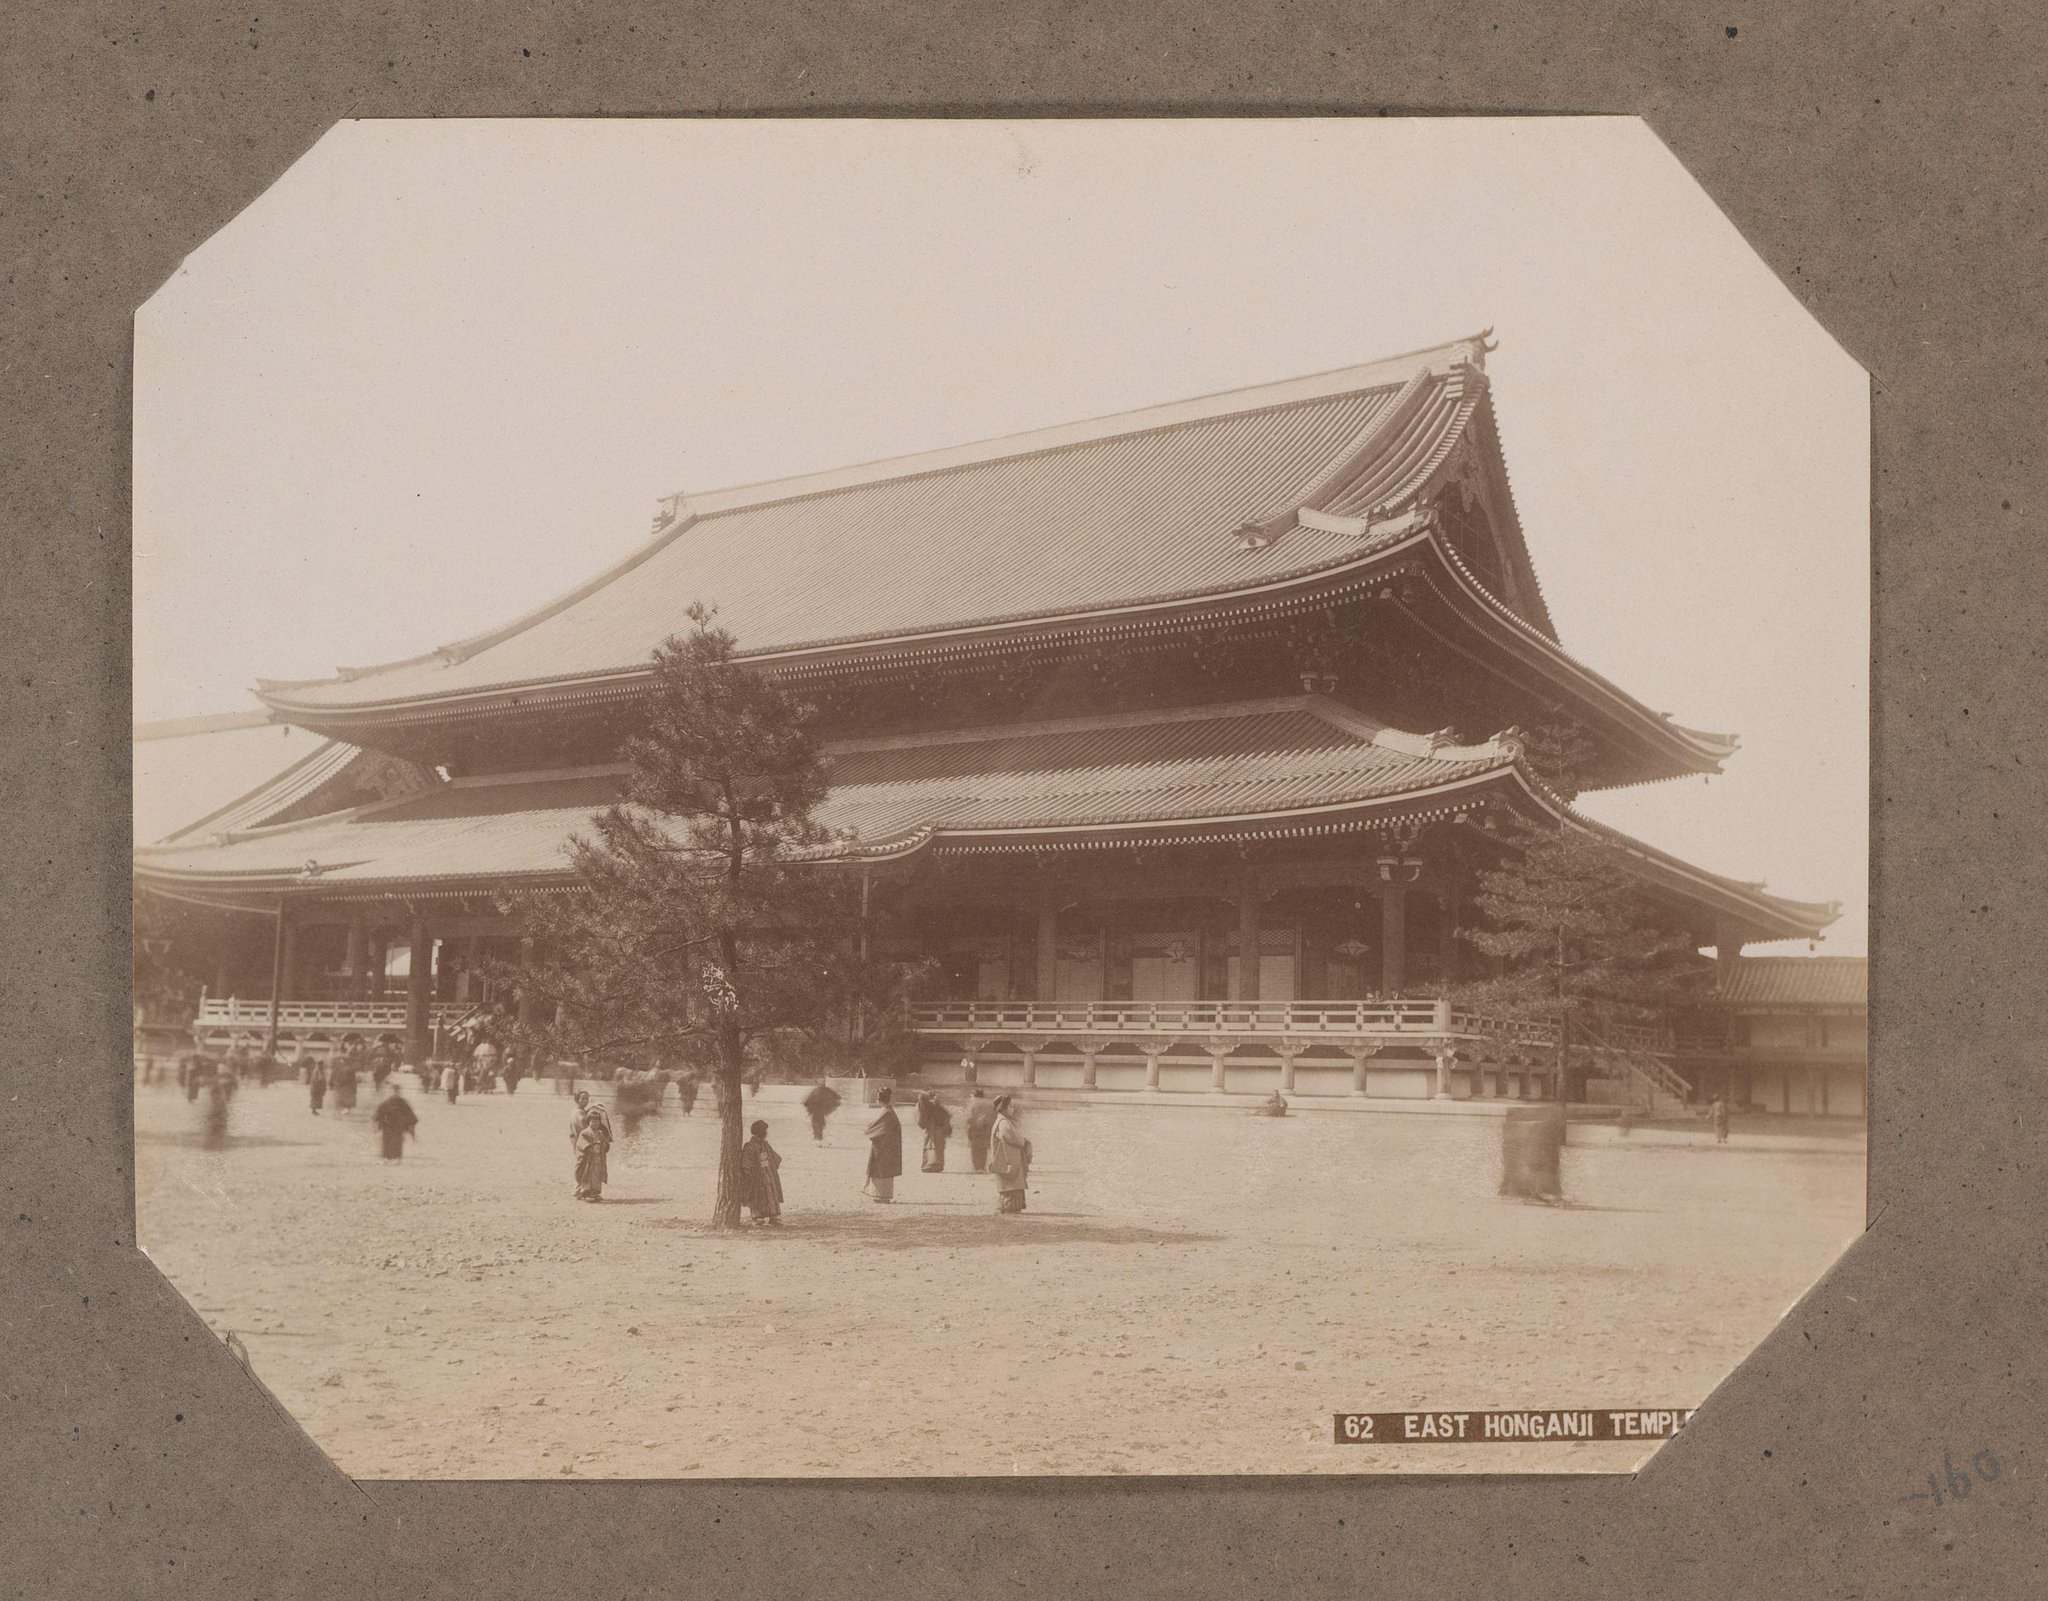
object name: photograph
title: Gezicht op de oostzijde van de Nishi Hongan-ji tempel in Kyoto, Japan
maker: Anonymous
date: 1890-1903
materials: paper, photographic support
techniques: albumen print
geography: kyoto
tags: temple, shrine ~ hinduism, buddhism, jainism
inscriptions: inscription: ‘62 East Honganji Temple - Kioto’